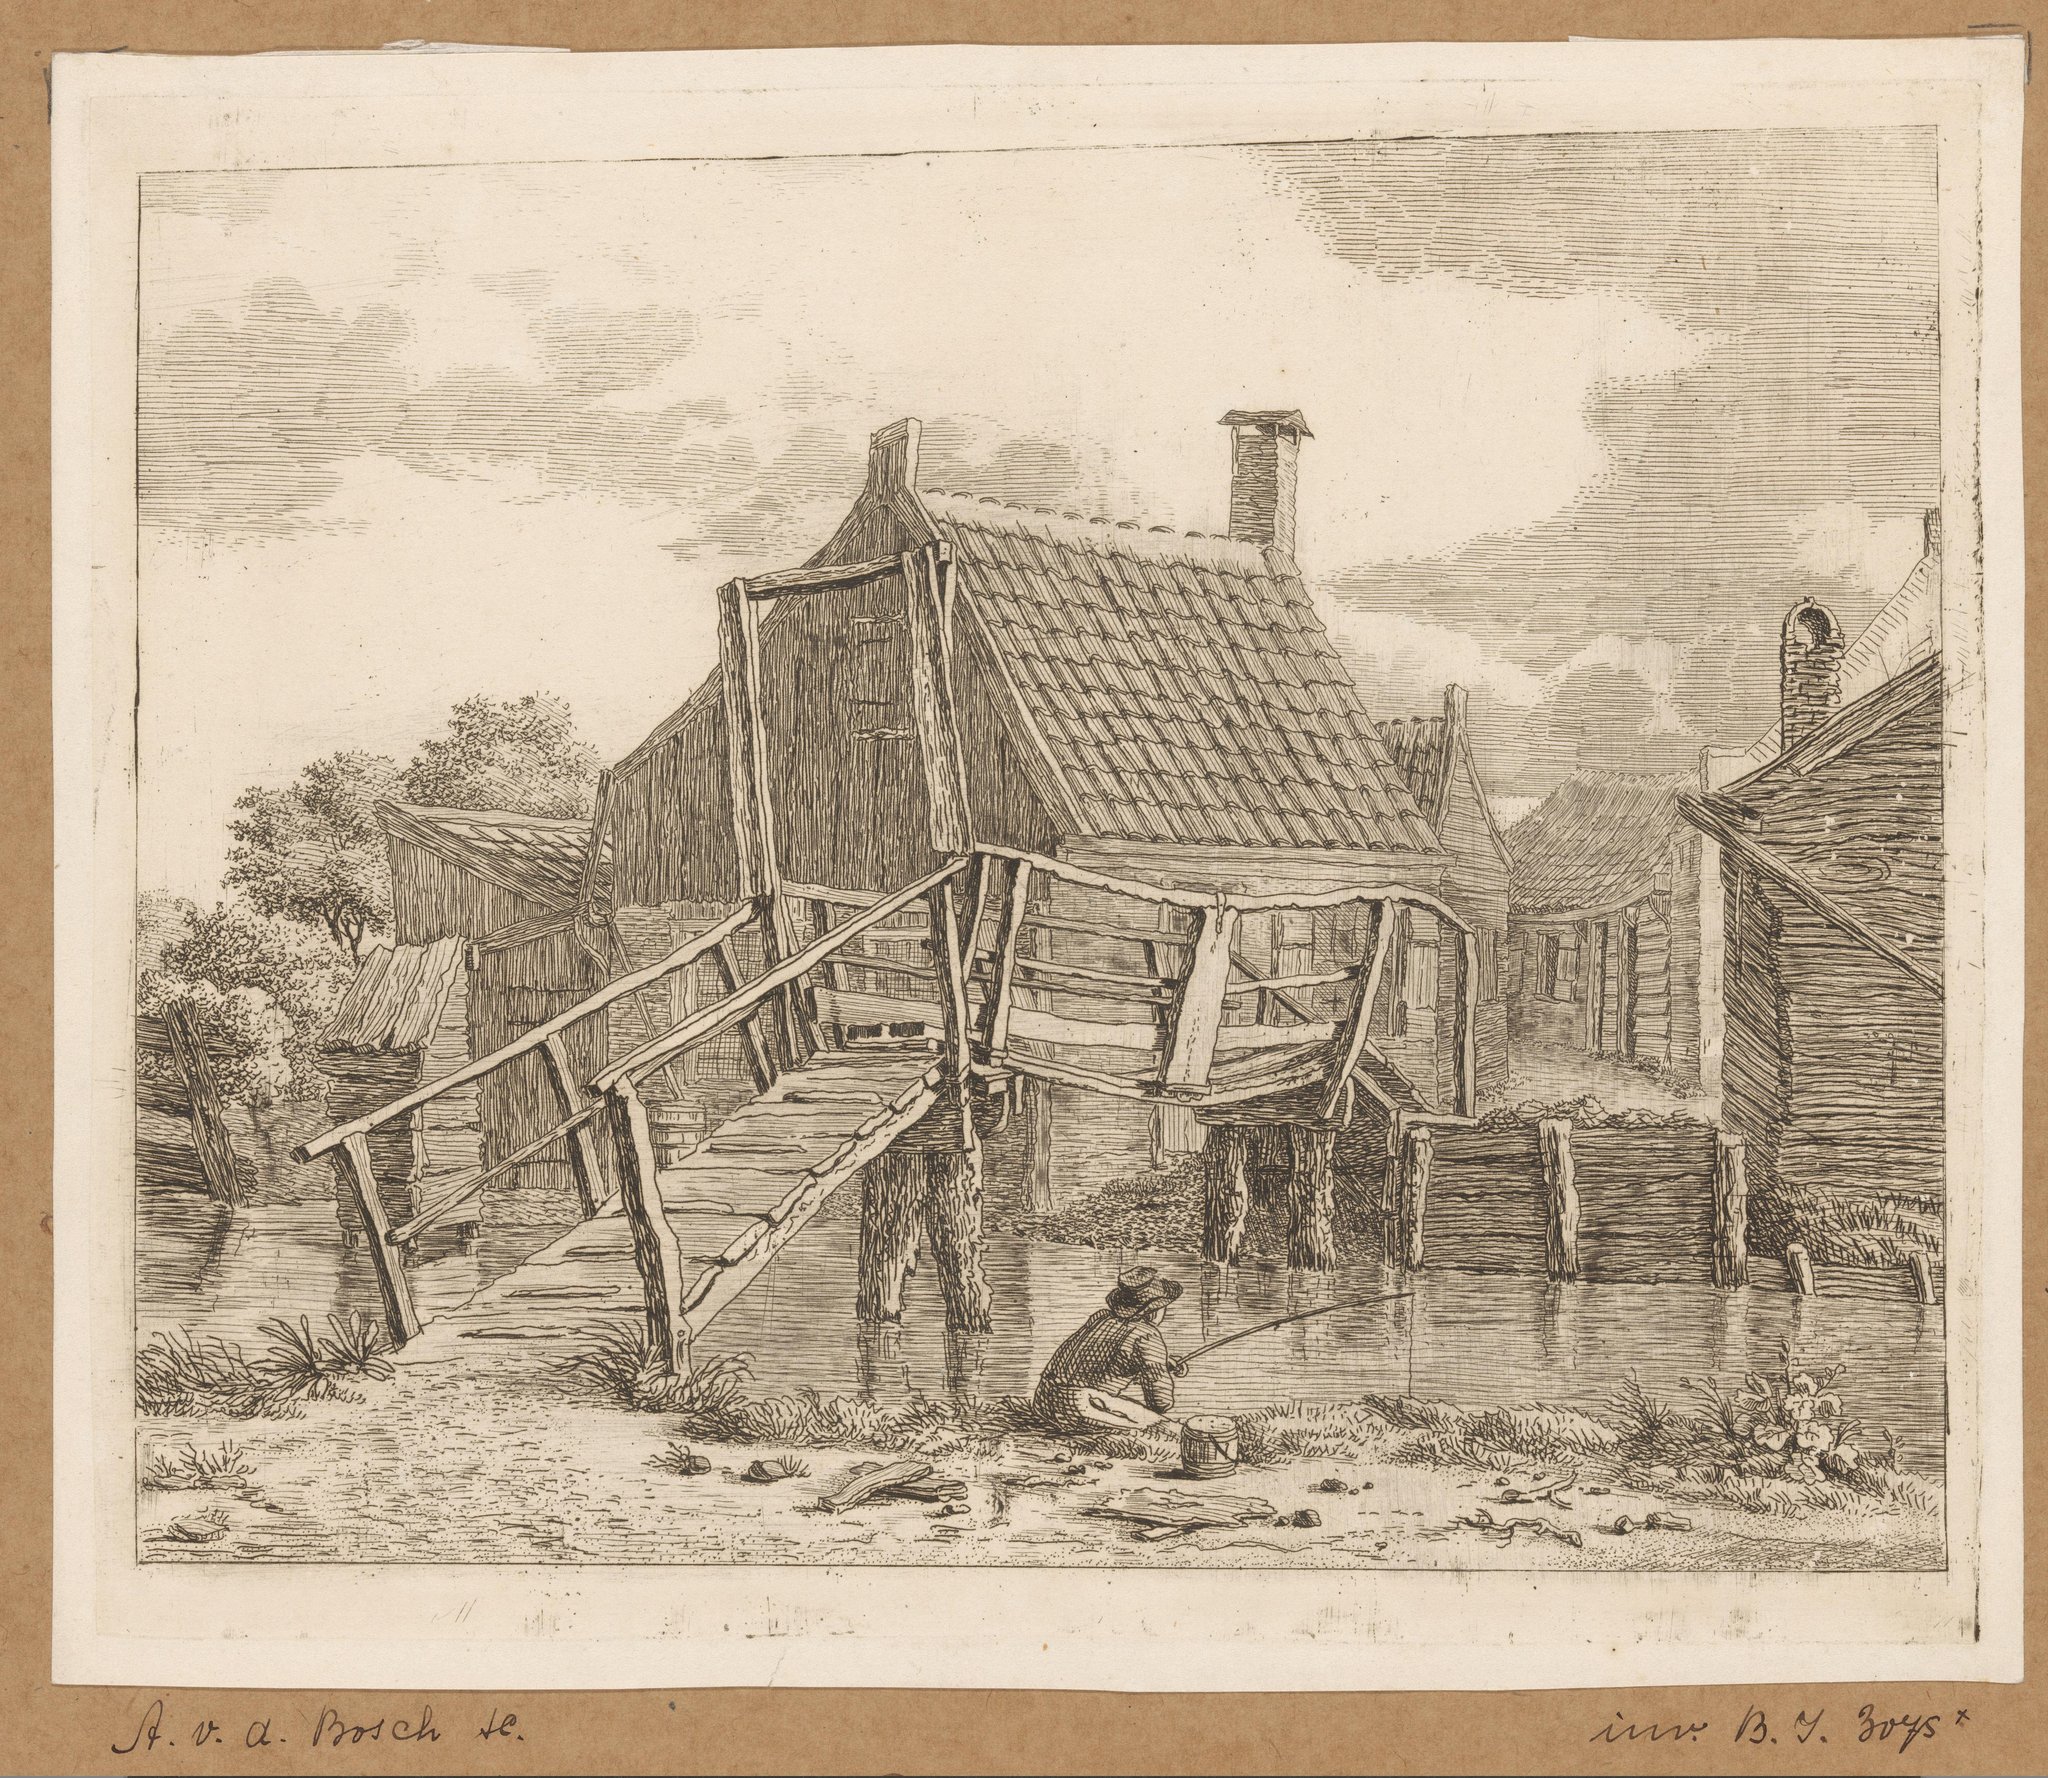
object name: print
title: Buiten de Raampoort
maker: anthonie van den bos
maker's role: draughtsman, print maker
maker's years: 1763-1838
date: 1773-1838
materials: paper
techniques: drypoint, etching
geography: netherlands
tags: angling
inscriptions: collector's mark: Lugt 2228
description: Een man zit aan de oever van een sloot te hengelen vlakbij een houten brug.